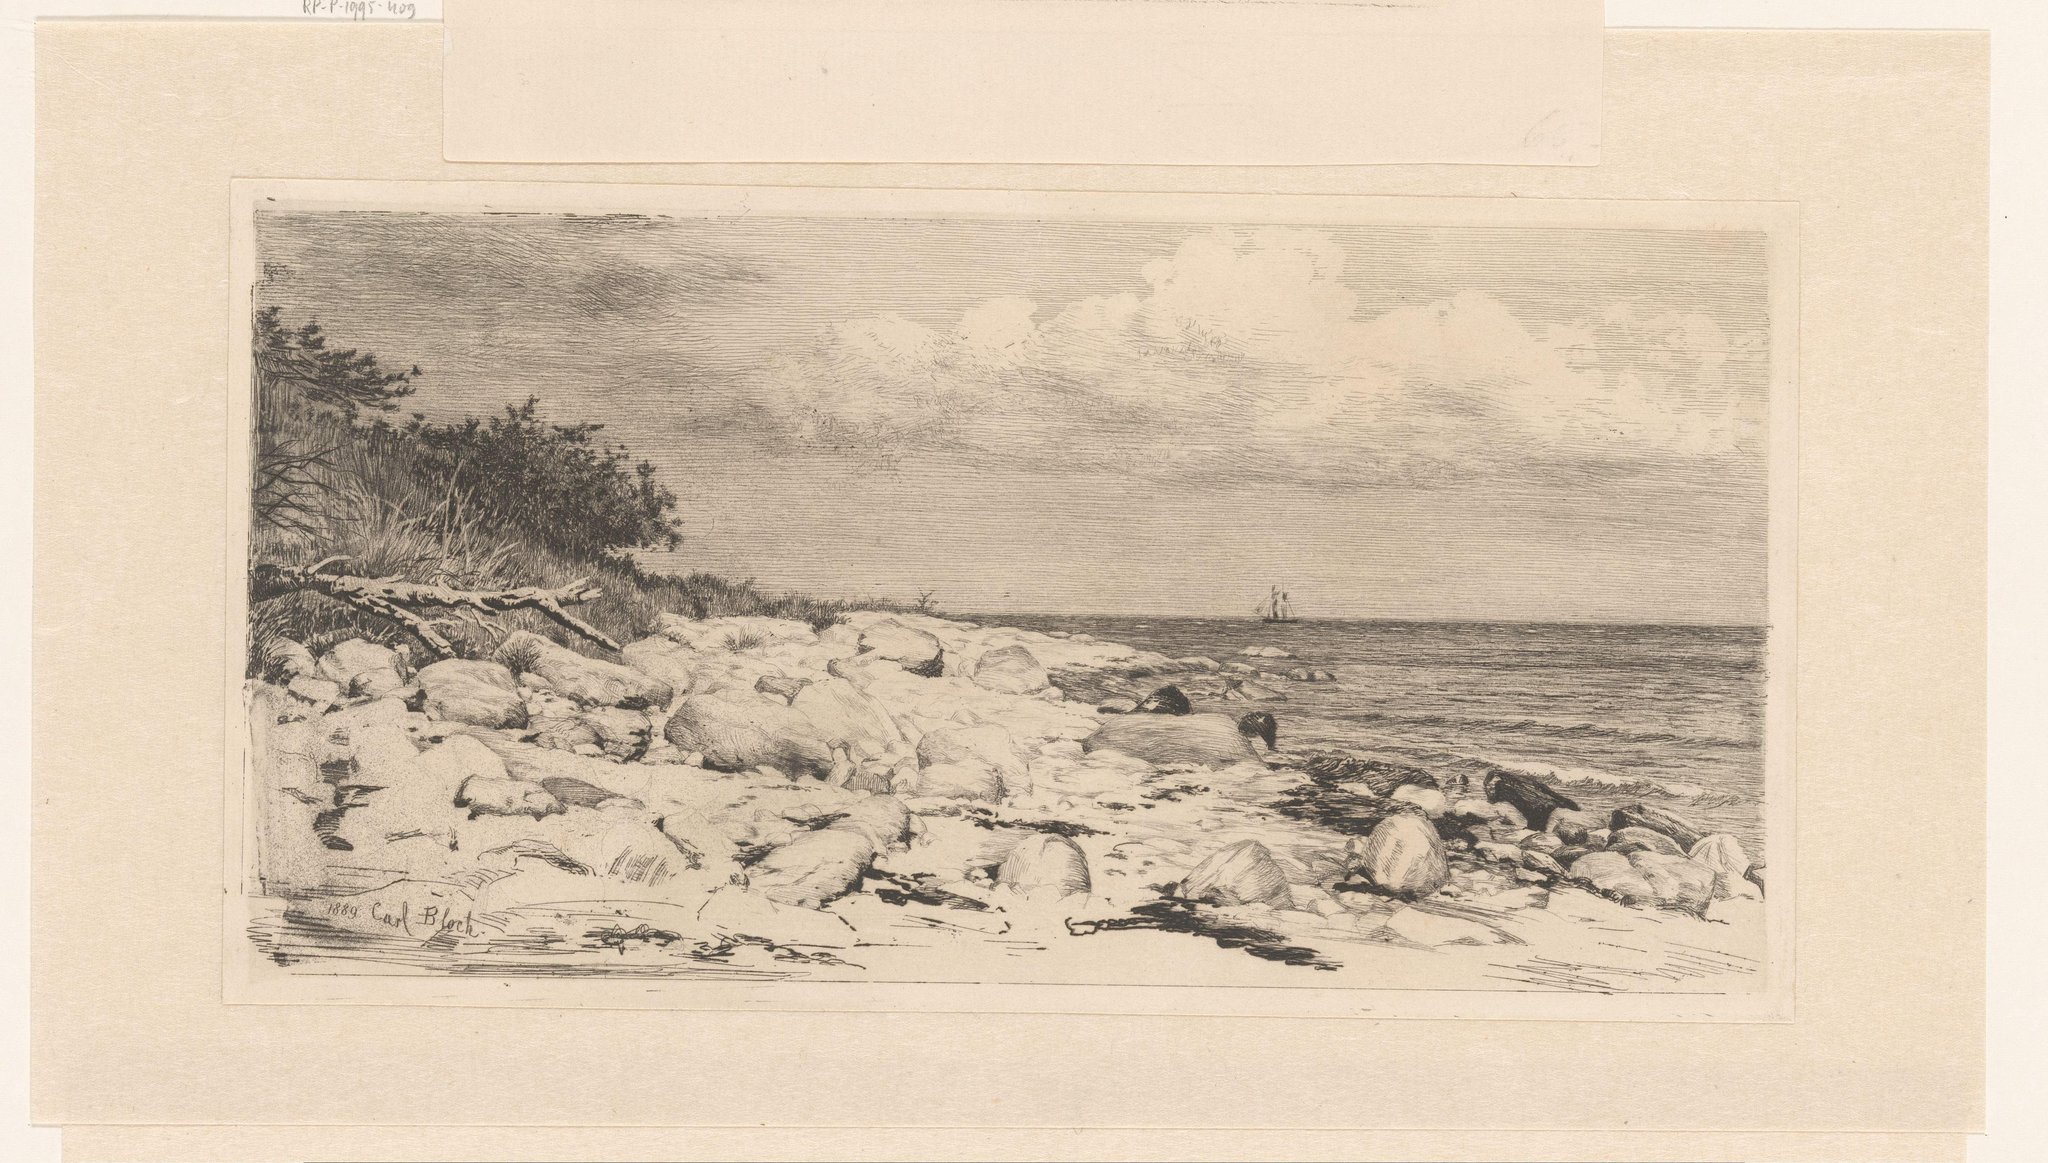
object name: print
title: Strand met keien, aan zee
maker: carl bloch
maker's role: print maker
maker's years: 1834-1890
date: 1889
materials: paper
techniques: drypoint, etching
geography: scandinavia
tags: rocky coast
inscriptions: collector's mark: Lugt 2228, signature and date: ‘l.o. gesigneerd en gedateerd: Carl Bloch 1889’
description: Strand met grote keien, links begin van een duin. Rechts de zee met in de verte een bootje.